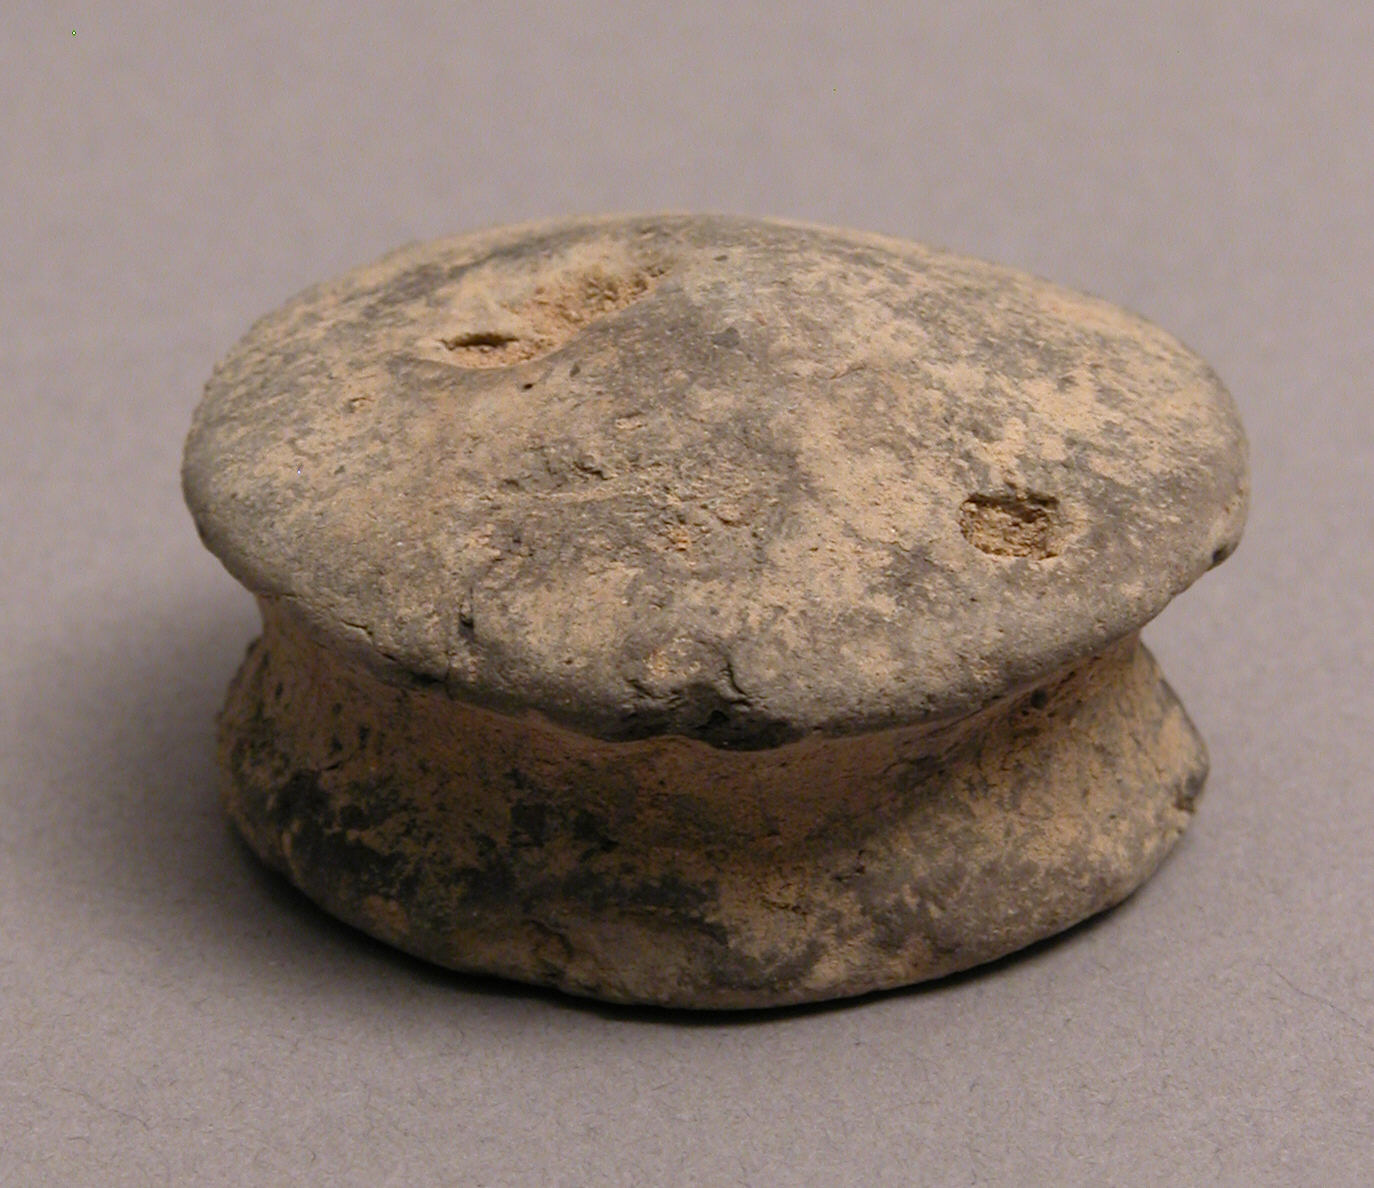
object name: game piece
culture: coptic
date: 301-700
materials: earthenware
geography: egypt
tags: games